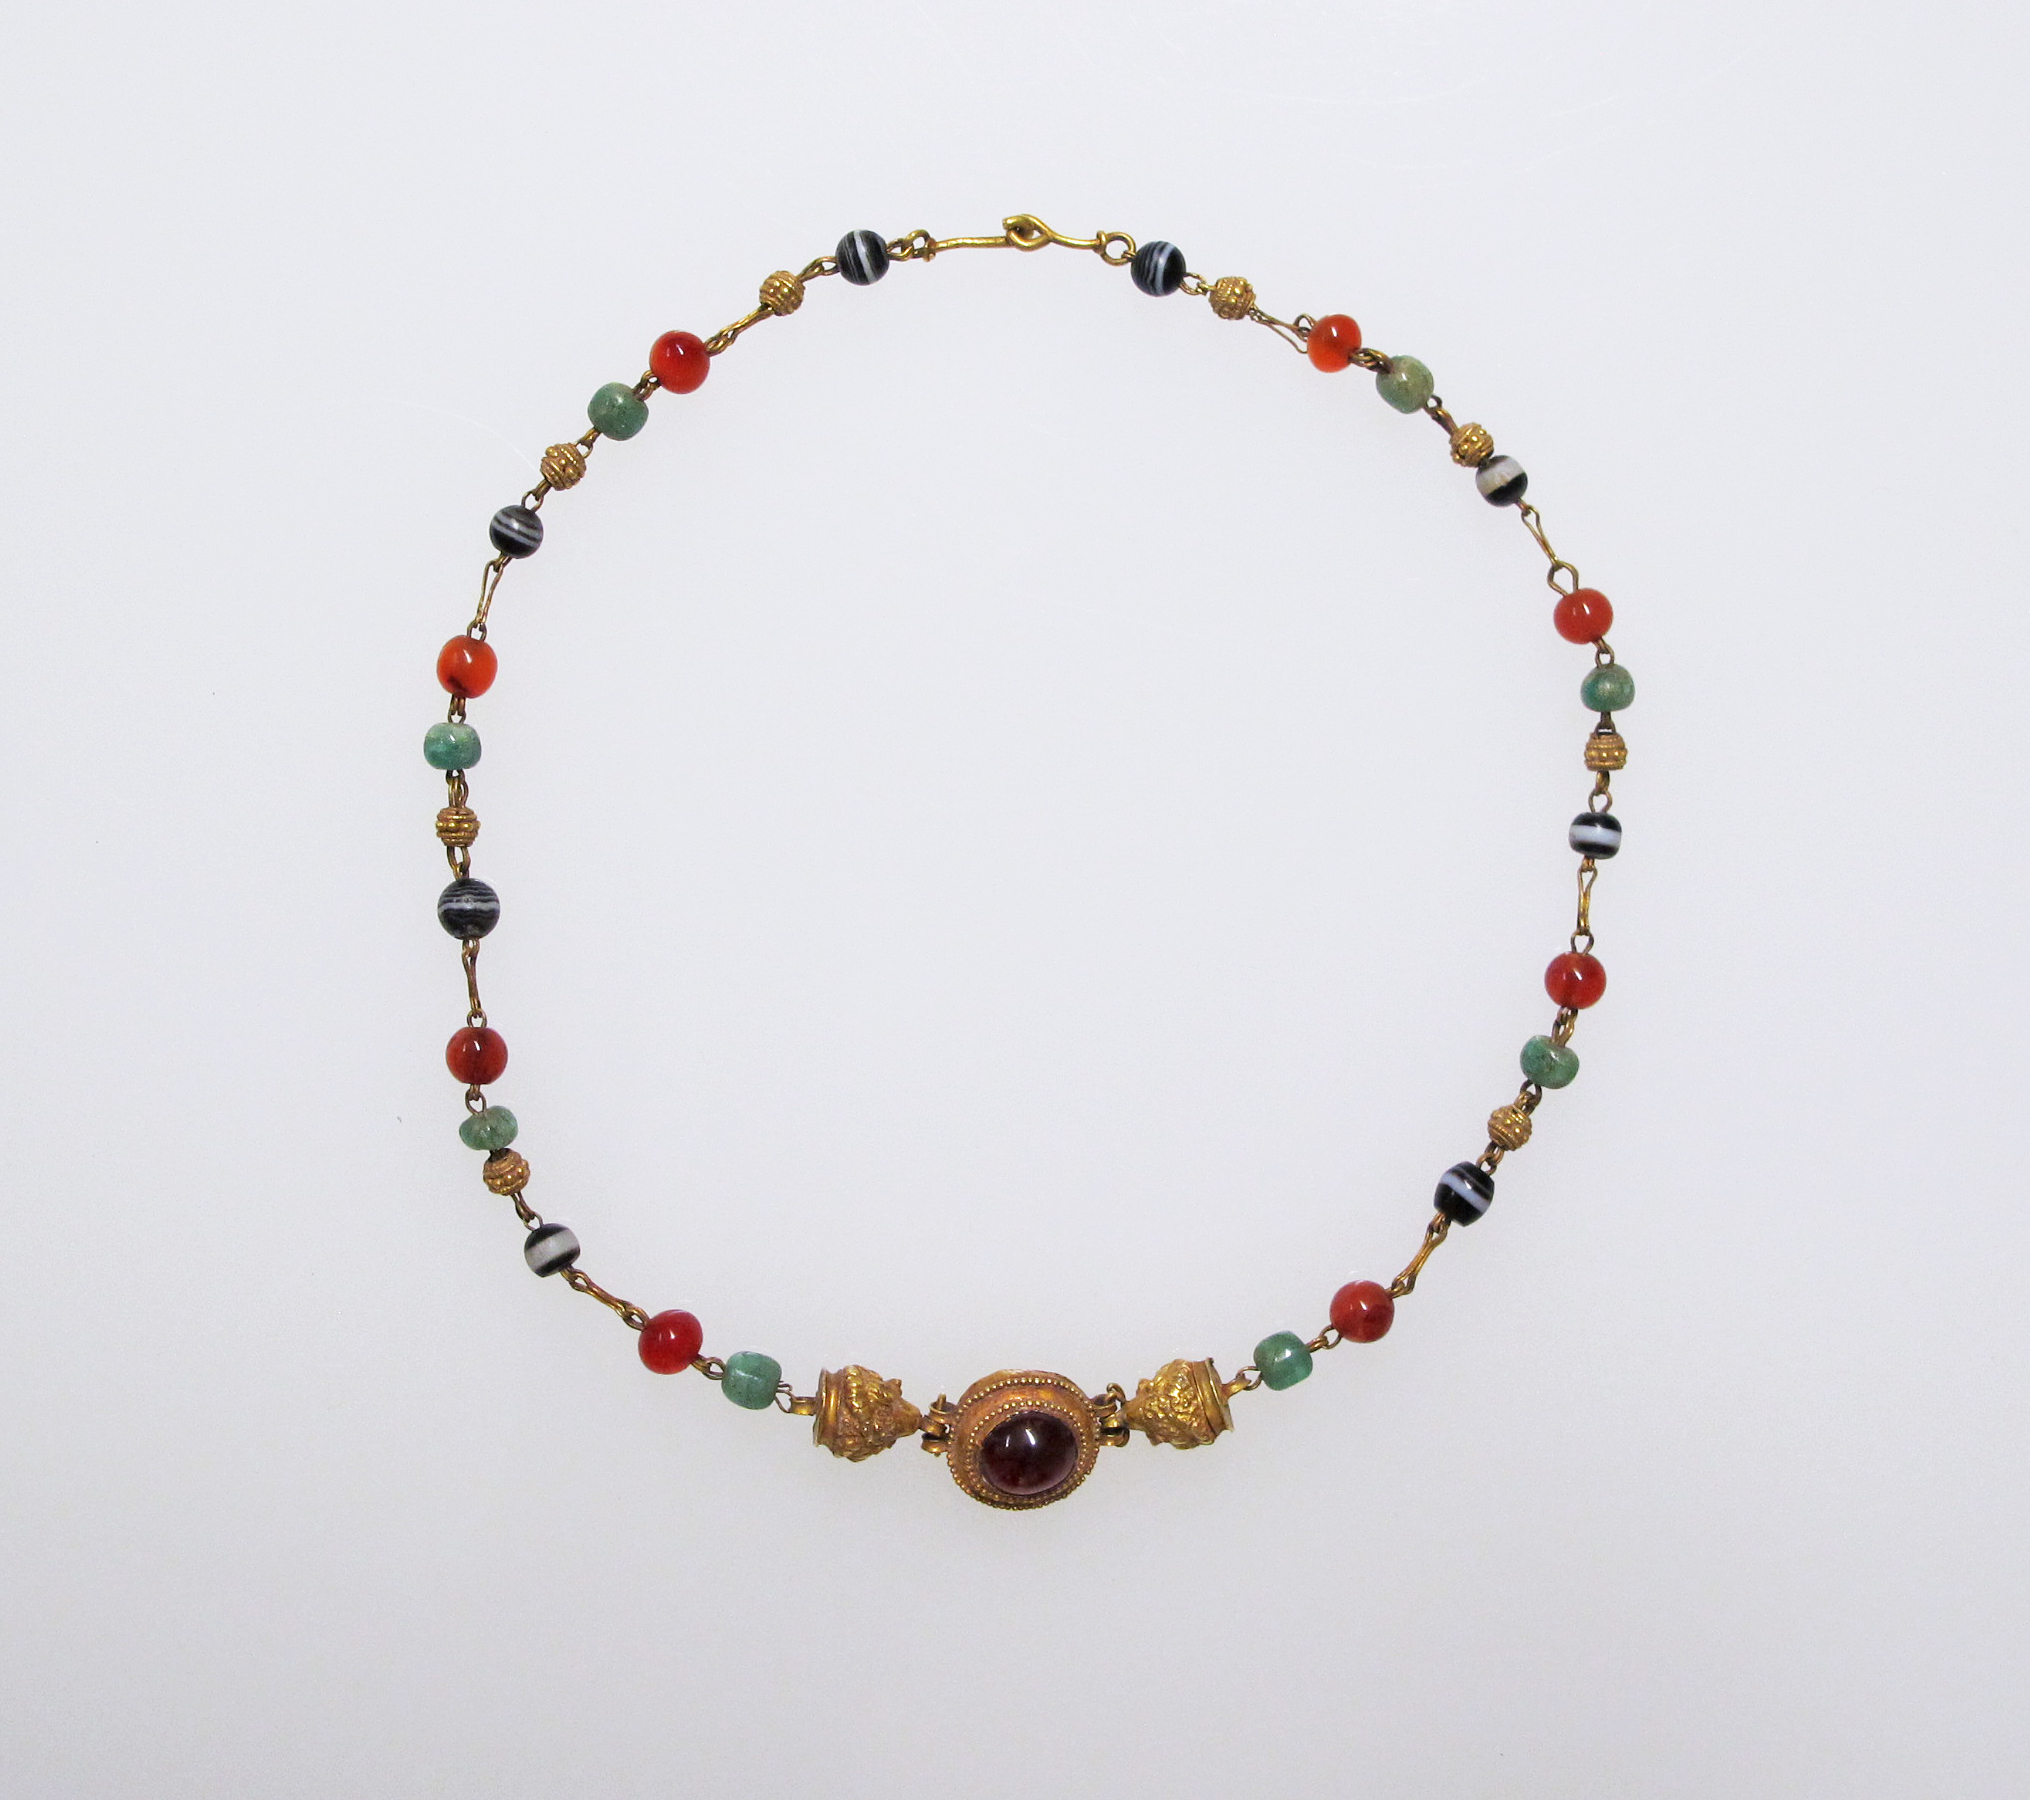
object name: necklace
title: Gold, emerald, carnelian, banded onyx, and garnet necklace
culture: roman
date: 1-100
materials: gemstone, gold, onyx